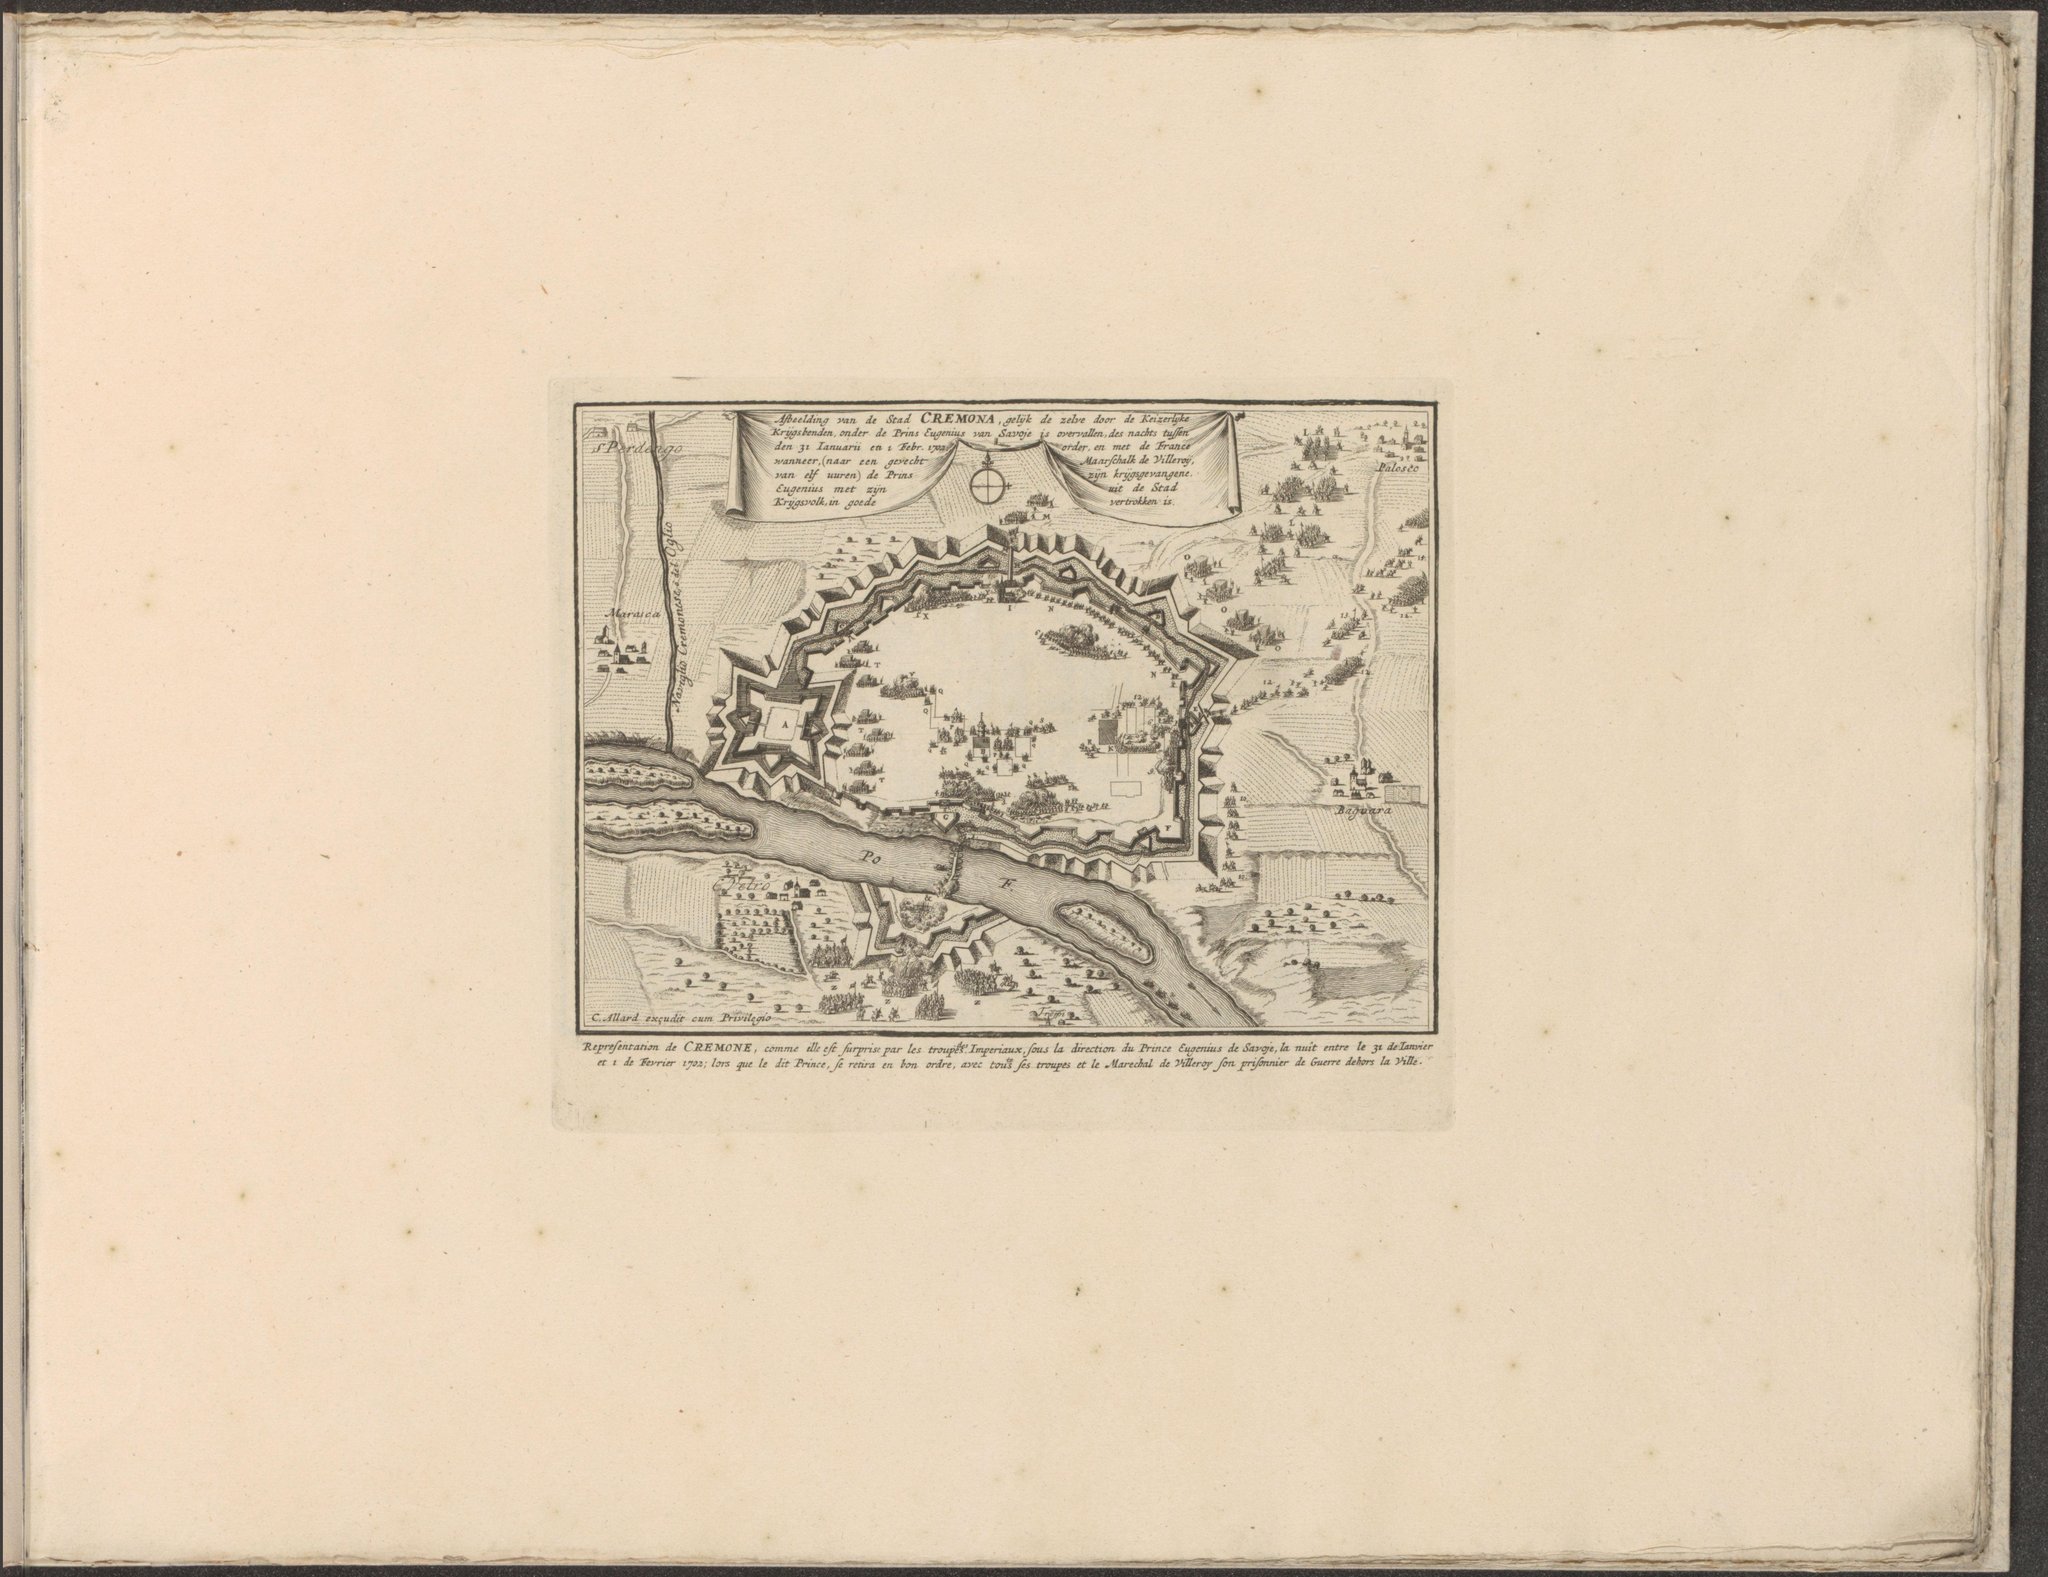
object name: map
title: Inname van Cremona, 1702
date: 1701-1733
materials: paper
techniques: etching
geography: leiden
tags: paris, vienna, eugenius van savoye, capture of city (after the siege), maps of cities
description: Plattegrond van Cremona, ingenomen door het keizerlijke leger onder prins Eugenius van Savoye in de nacht van 31 januari op 1 februari 1702. Kort daarop heroveren de Fransen de stad. Met teksten in het Nederlands en Frans. De prent maakt deel uit van een album.